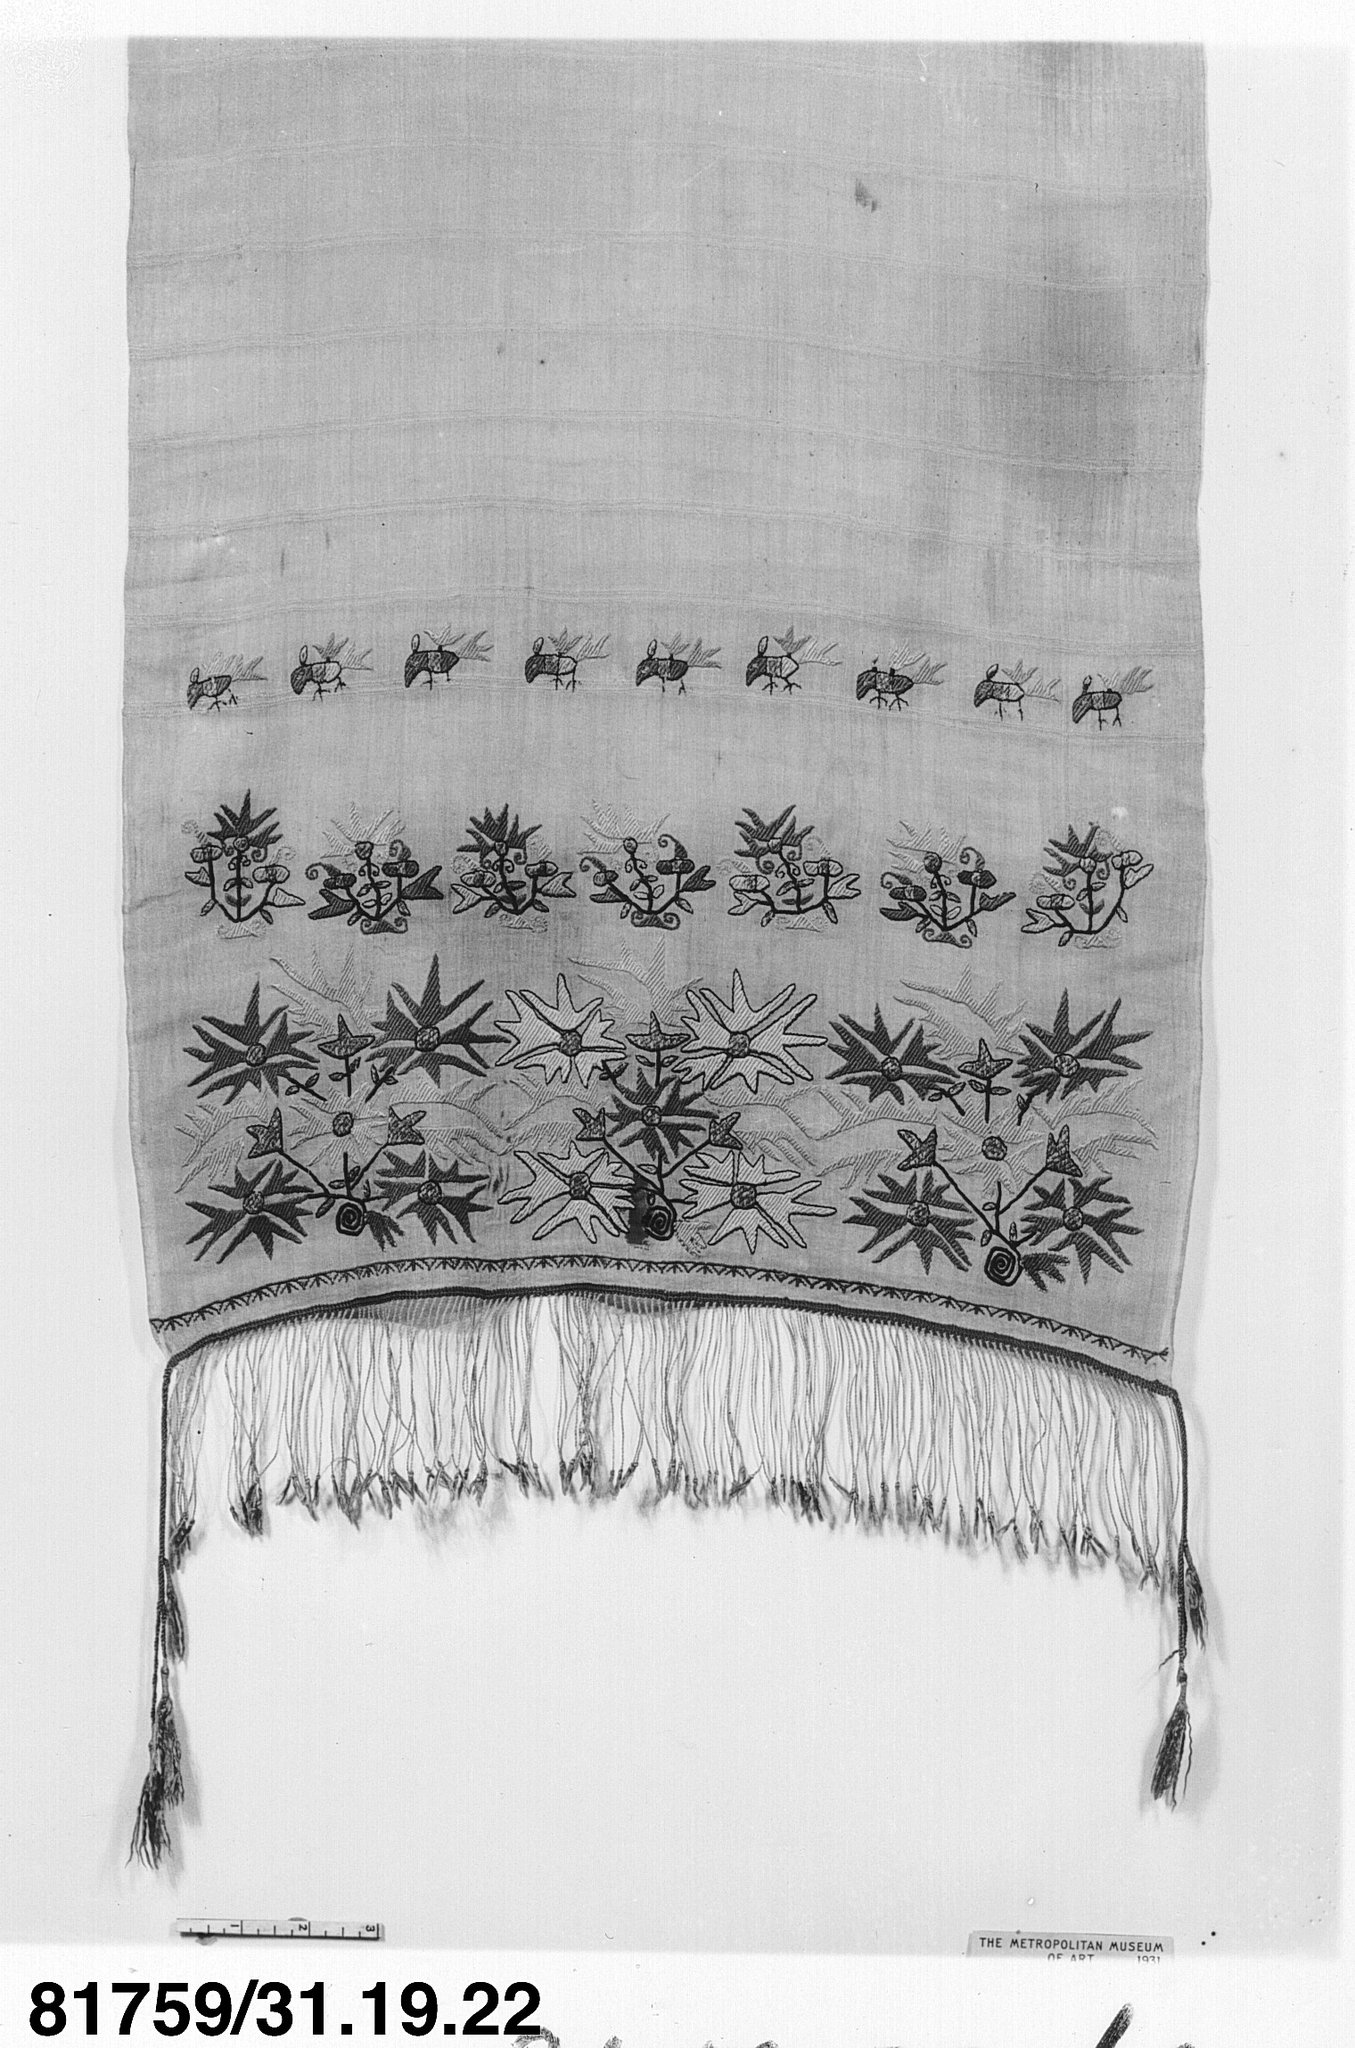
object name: scarf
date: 1701-1800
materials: cotton, silk